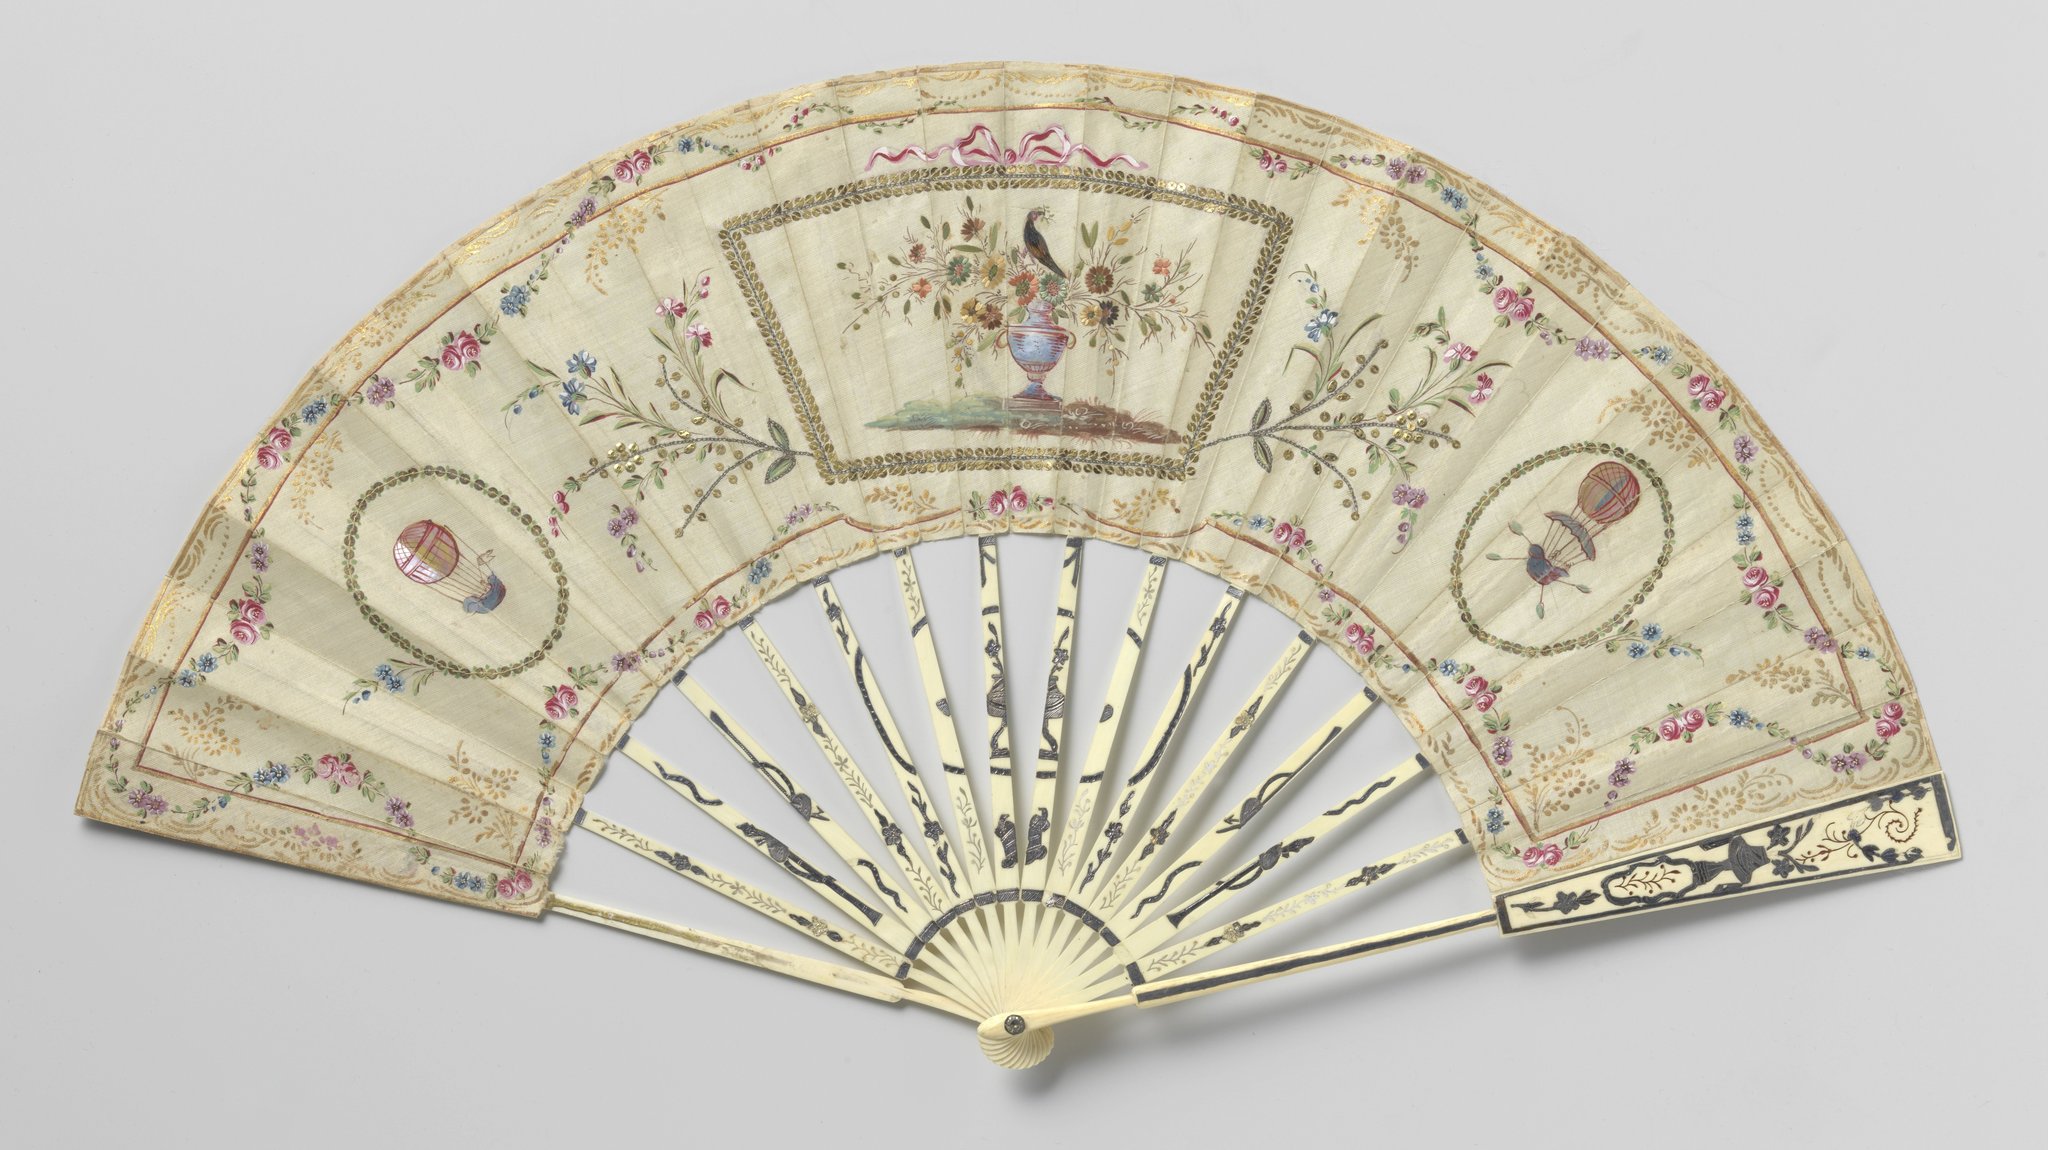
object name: vouwwaaier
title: Vouwwaaier, blad van zijde beschilderd met gouache en versierd met stro, veren en parelmoer en metalen lovertjes: centrale cartouche met een vogel op een bloemenvaas en twee kleinere ovalen met de ballonvaarten van resp. de gebroeders Montgolfier en Jean-Pierre Blanchard, op een montuur van à-jour gesneden en met zilver ingelegd been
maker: Anonymous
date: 1784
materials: bone, feather, glass, gouache, metal, mother of pearl, paint, silk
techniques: cutting, embroidery, grinding, inlay, weave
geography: france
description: Vouwwaaier, blad van zijde beschilderd met gouache en versierd met stro, veren en parelmoer en metalen lovertjes: centrale cartouche met een vogel op een bloemenvaas en twee kleinere ovalen met de ballonvaarten van resp. de gebroeders Montgolfier en Jean-Pierre Blanchard '(éventail) au ballon', op een montuur van à-jour gesneden en met zilver ingelegd been. De centrale rechthoek is als een miniatuur weergegeven met een lijst van goudkleurige lovers en een geschilderd striklint. Hierin bevindt zich een vaas van beschilderd parelmoer met bloemen van stro en een vogel met echte veertjes. Op het open montuur wordt het motief van de vaas met bloemen herhaald in het centrale medaillon en op het steundeel van de buitenbenen. Sluitpin van geslepen glas (stras) in zilveren zetting. Voor de versiering is hier niet alleen gebruik gemaakt van lovers en schilderingen, zoals bij de meeste waaiers au ballon, maar ook van andere, enigszins ongebruikelijke materialen. In het rechthoekige miniatuur midden op het blad dat in trompe-l'oeuil is weergegeven met een lijst van goudkleurige pailletten en een geschilderd striklint, bevindt zich een vaas van beschilderd parelmoer met bloemen van stro en een vogel met echte veertjes. Op het montuur wordt het motief van de vaas met bloemen herhaald in het centrale medaillon en op het steundeel van de buitenbenen.